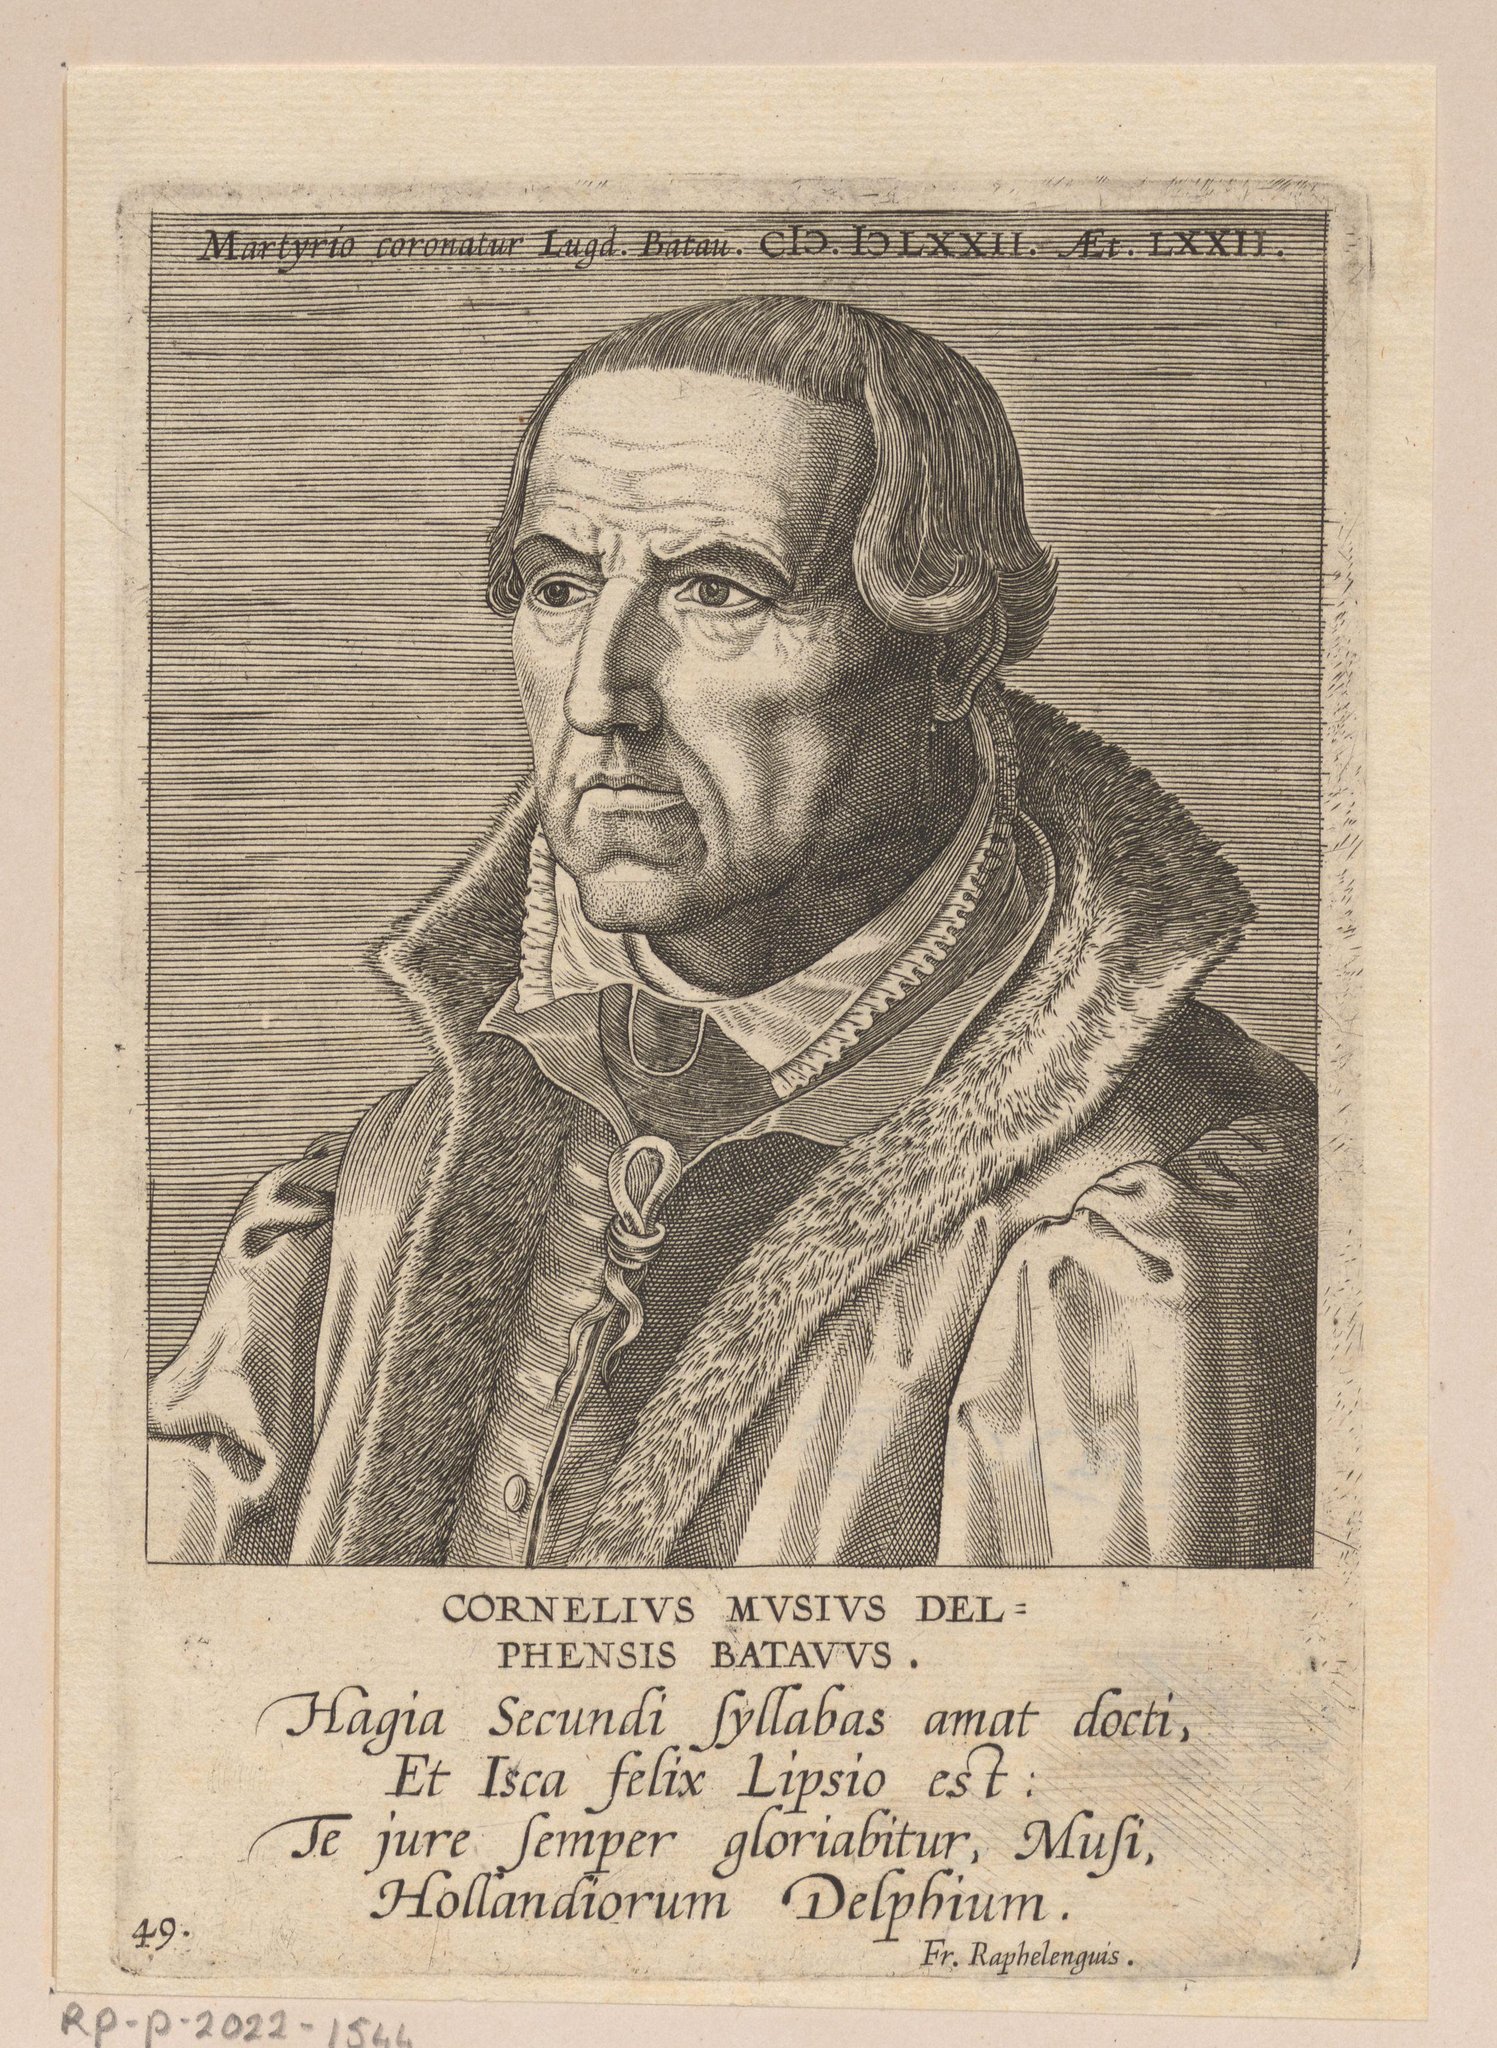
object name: print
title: Portretten van beroemde Nederlandse en Vlaamse geleerden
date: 1604-1610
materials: paper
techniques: engraving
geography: antwerp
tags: delft, cornelis musius, historical persons, portrait of a writer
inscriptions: collector's mark: Lugt 2228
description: Met vierregelig onderschrift in het Latijn. Linksonder: 49.